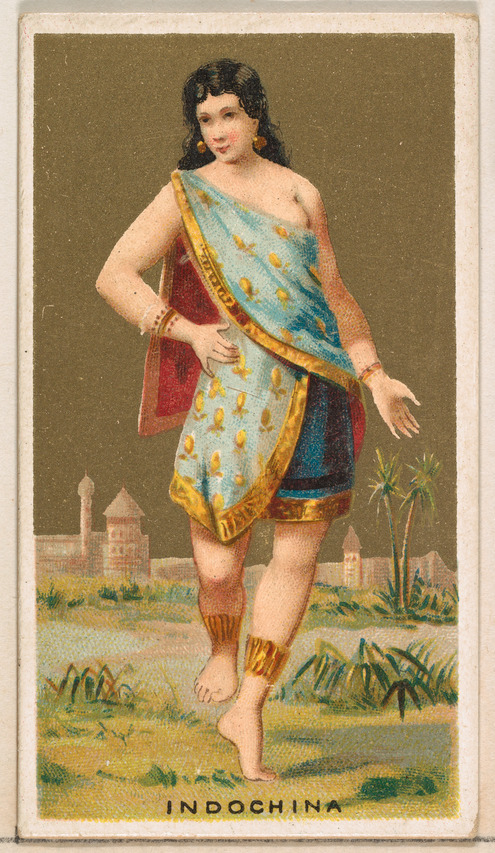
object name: print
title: Indochina, from the Dancing Girls of the World series (N185) issued by Wm. S. Kimball & Co.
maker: william s. kimball & company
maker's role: publisher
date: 1889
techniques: color lithograph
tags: women,dancing,dancers